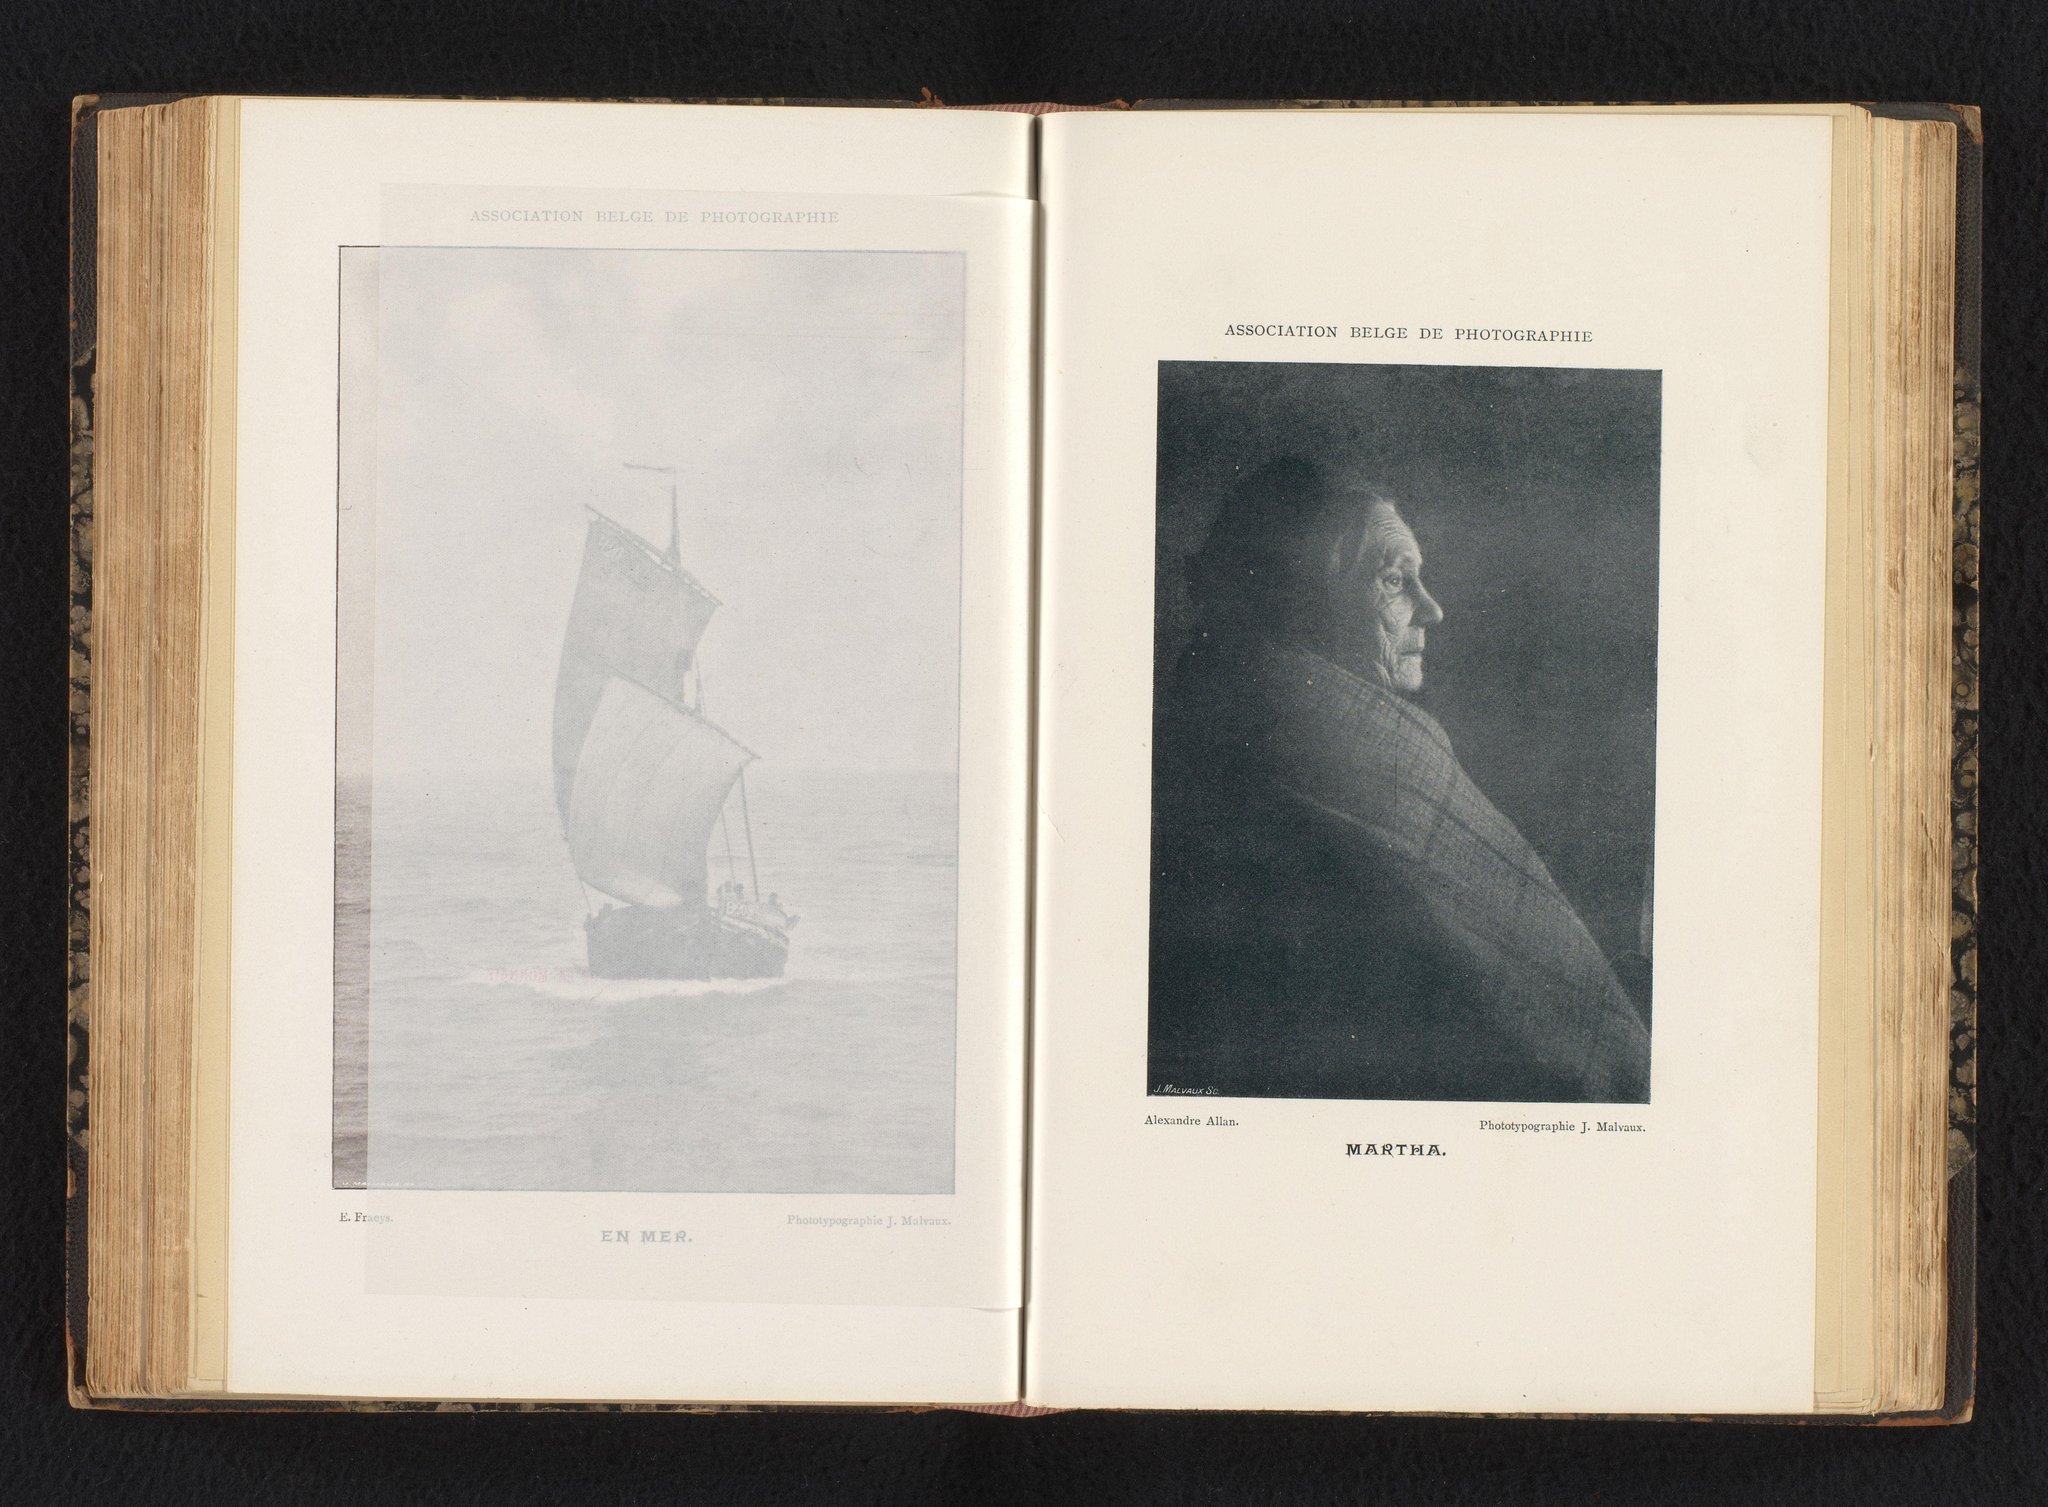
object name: photomechanical print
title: Portret van een onbekende vrouw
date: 1893-1898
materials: paper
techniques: autotype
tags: historical persons, old woman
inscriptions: inscription: ‘Association belge de photographie’